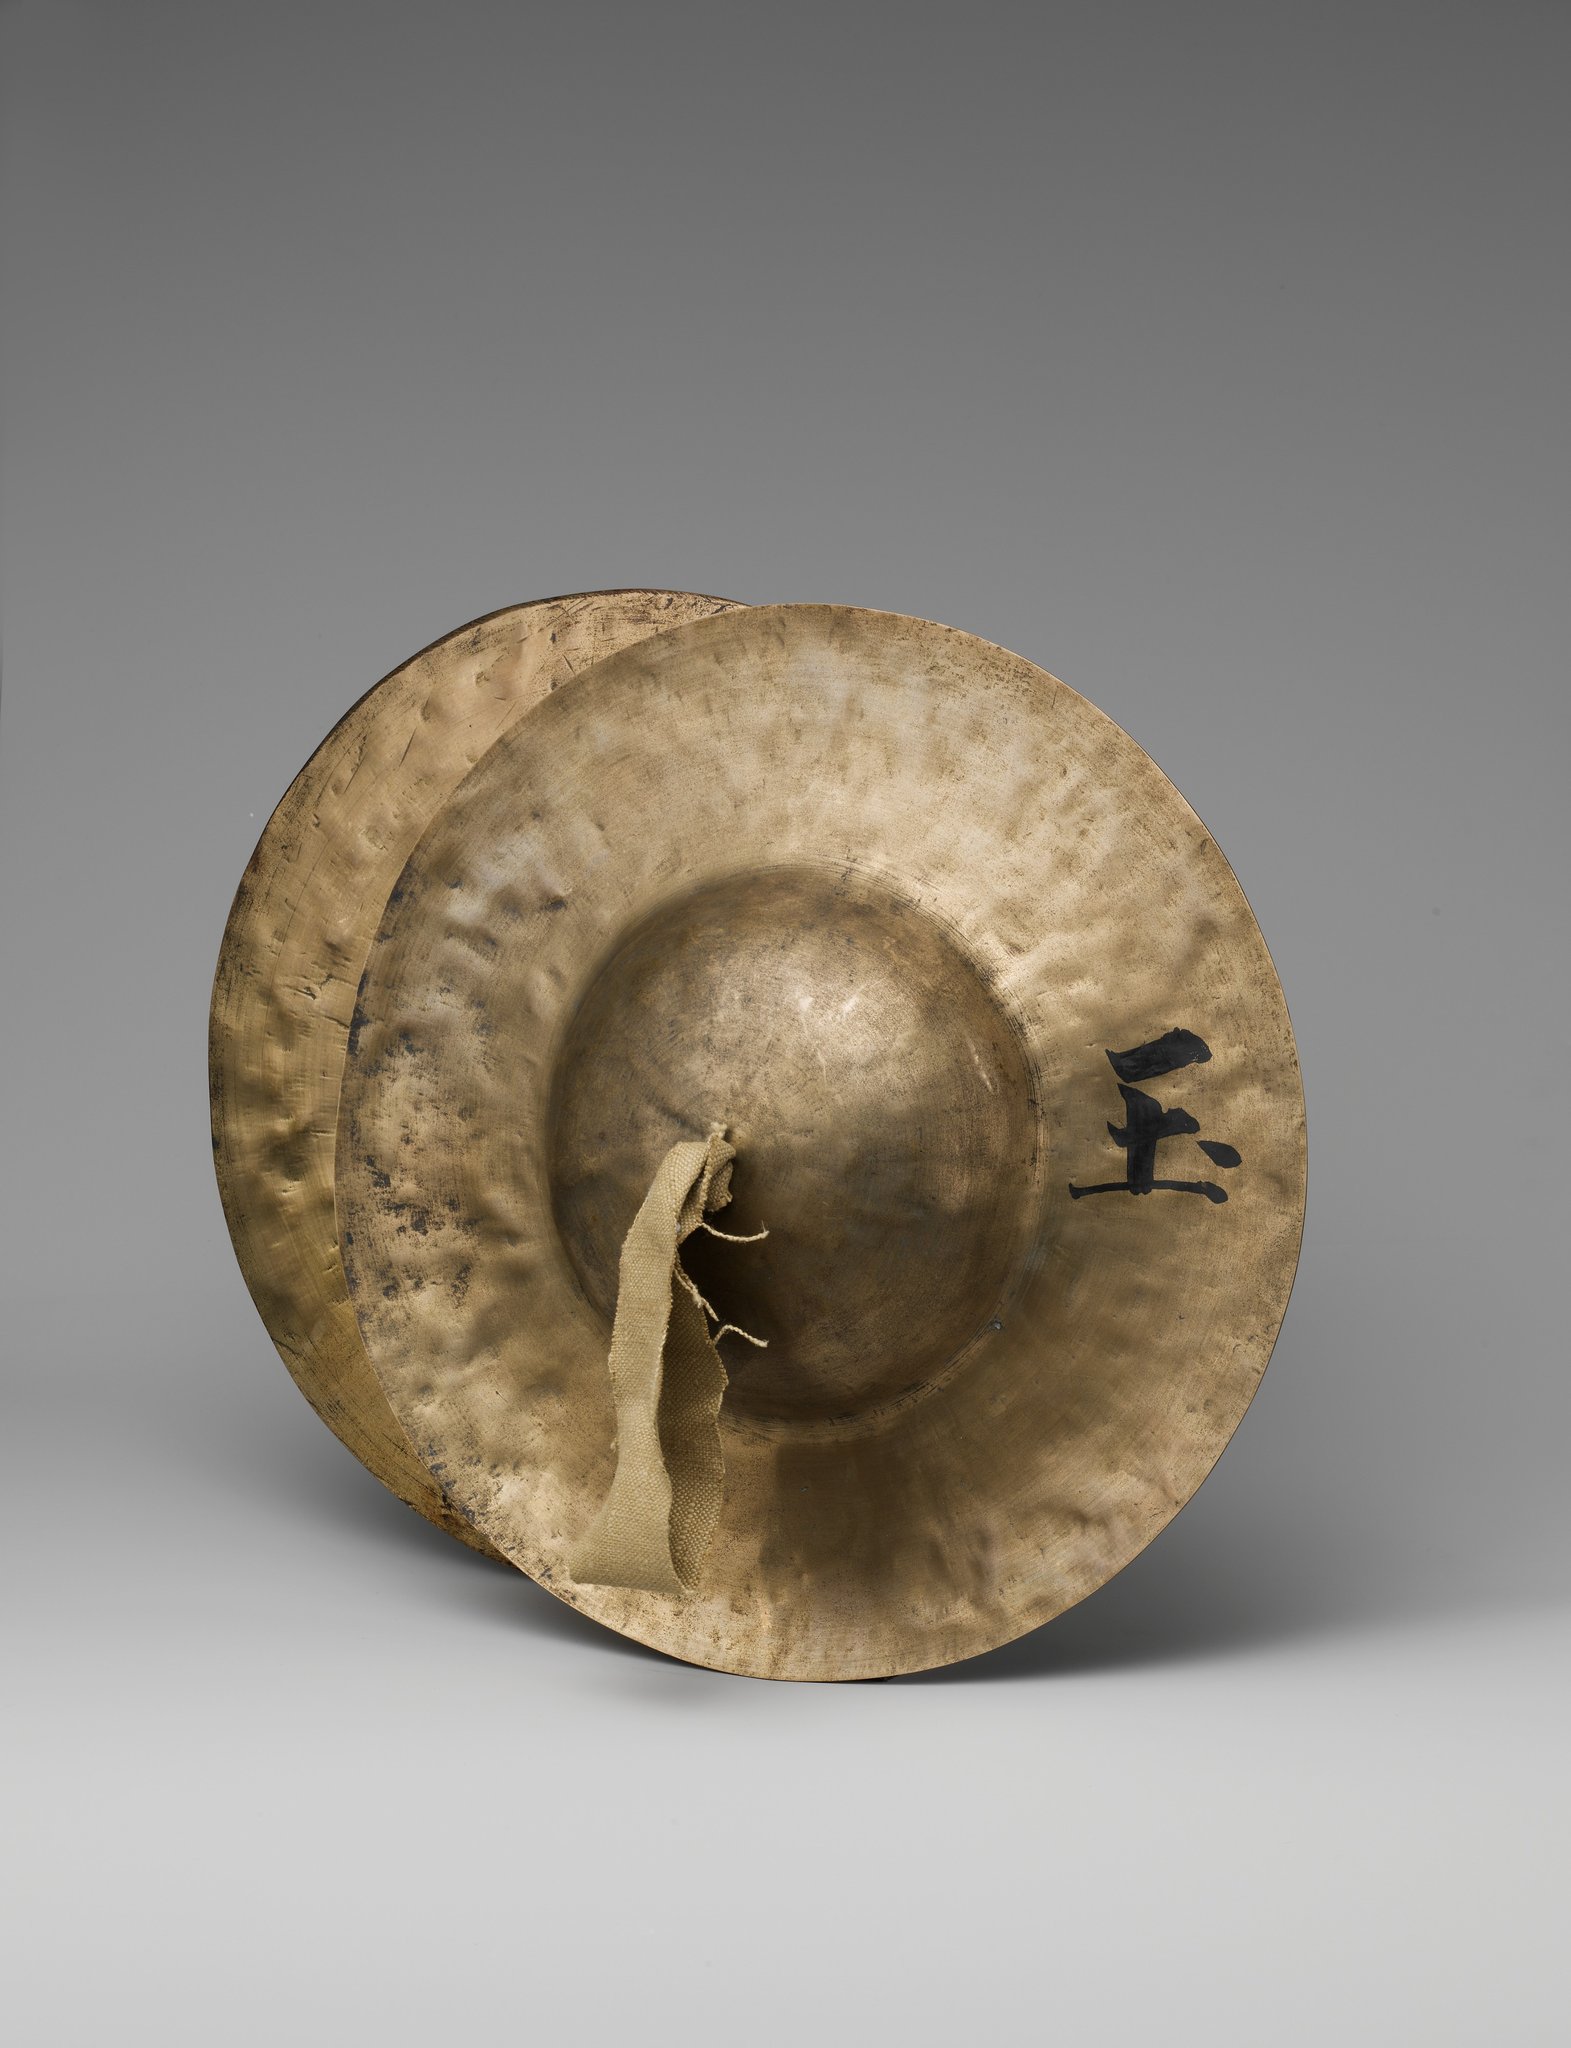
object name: bo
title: Bo (鈸 )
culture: chinese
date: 1801-1900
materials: bronze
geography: china